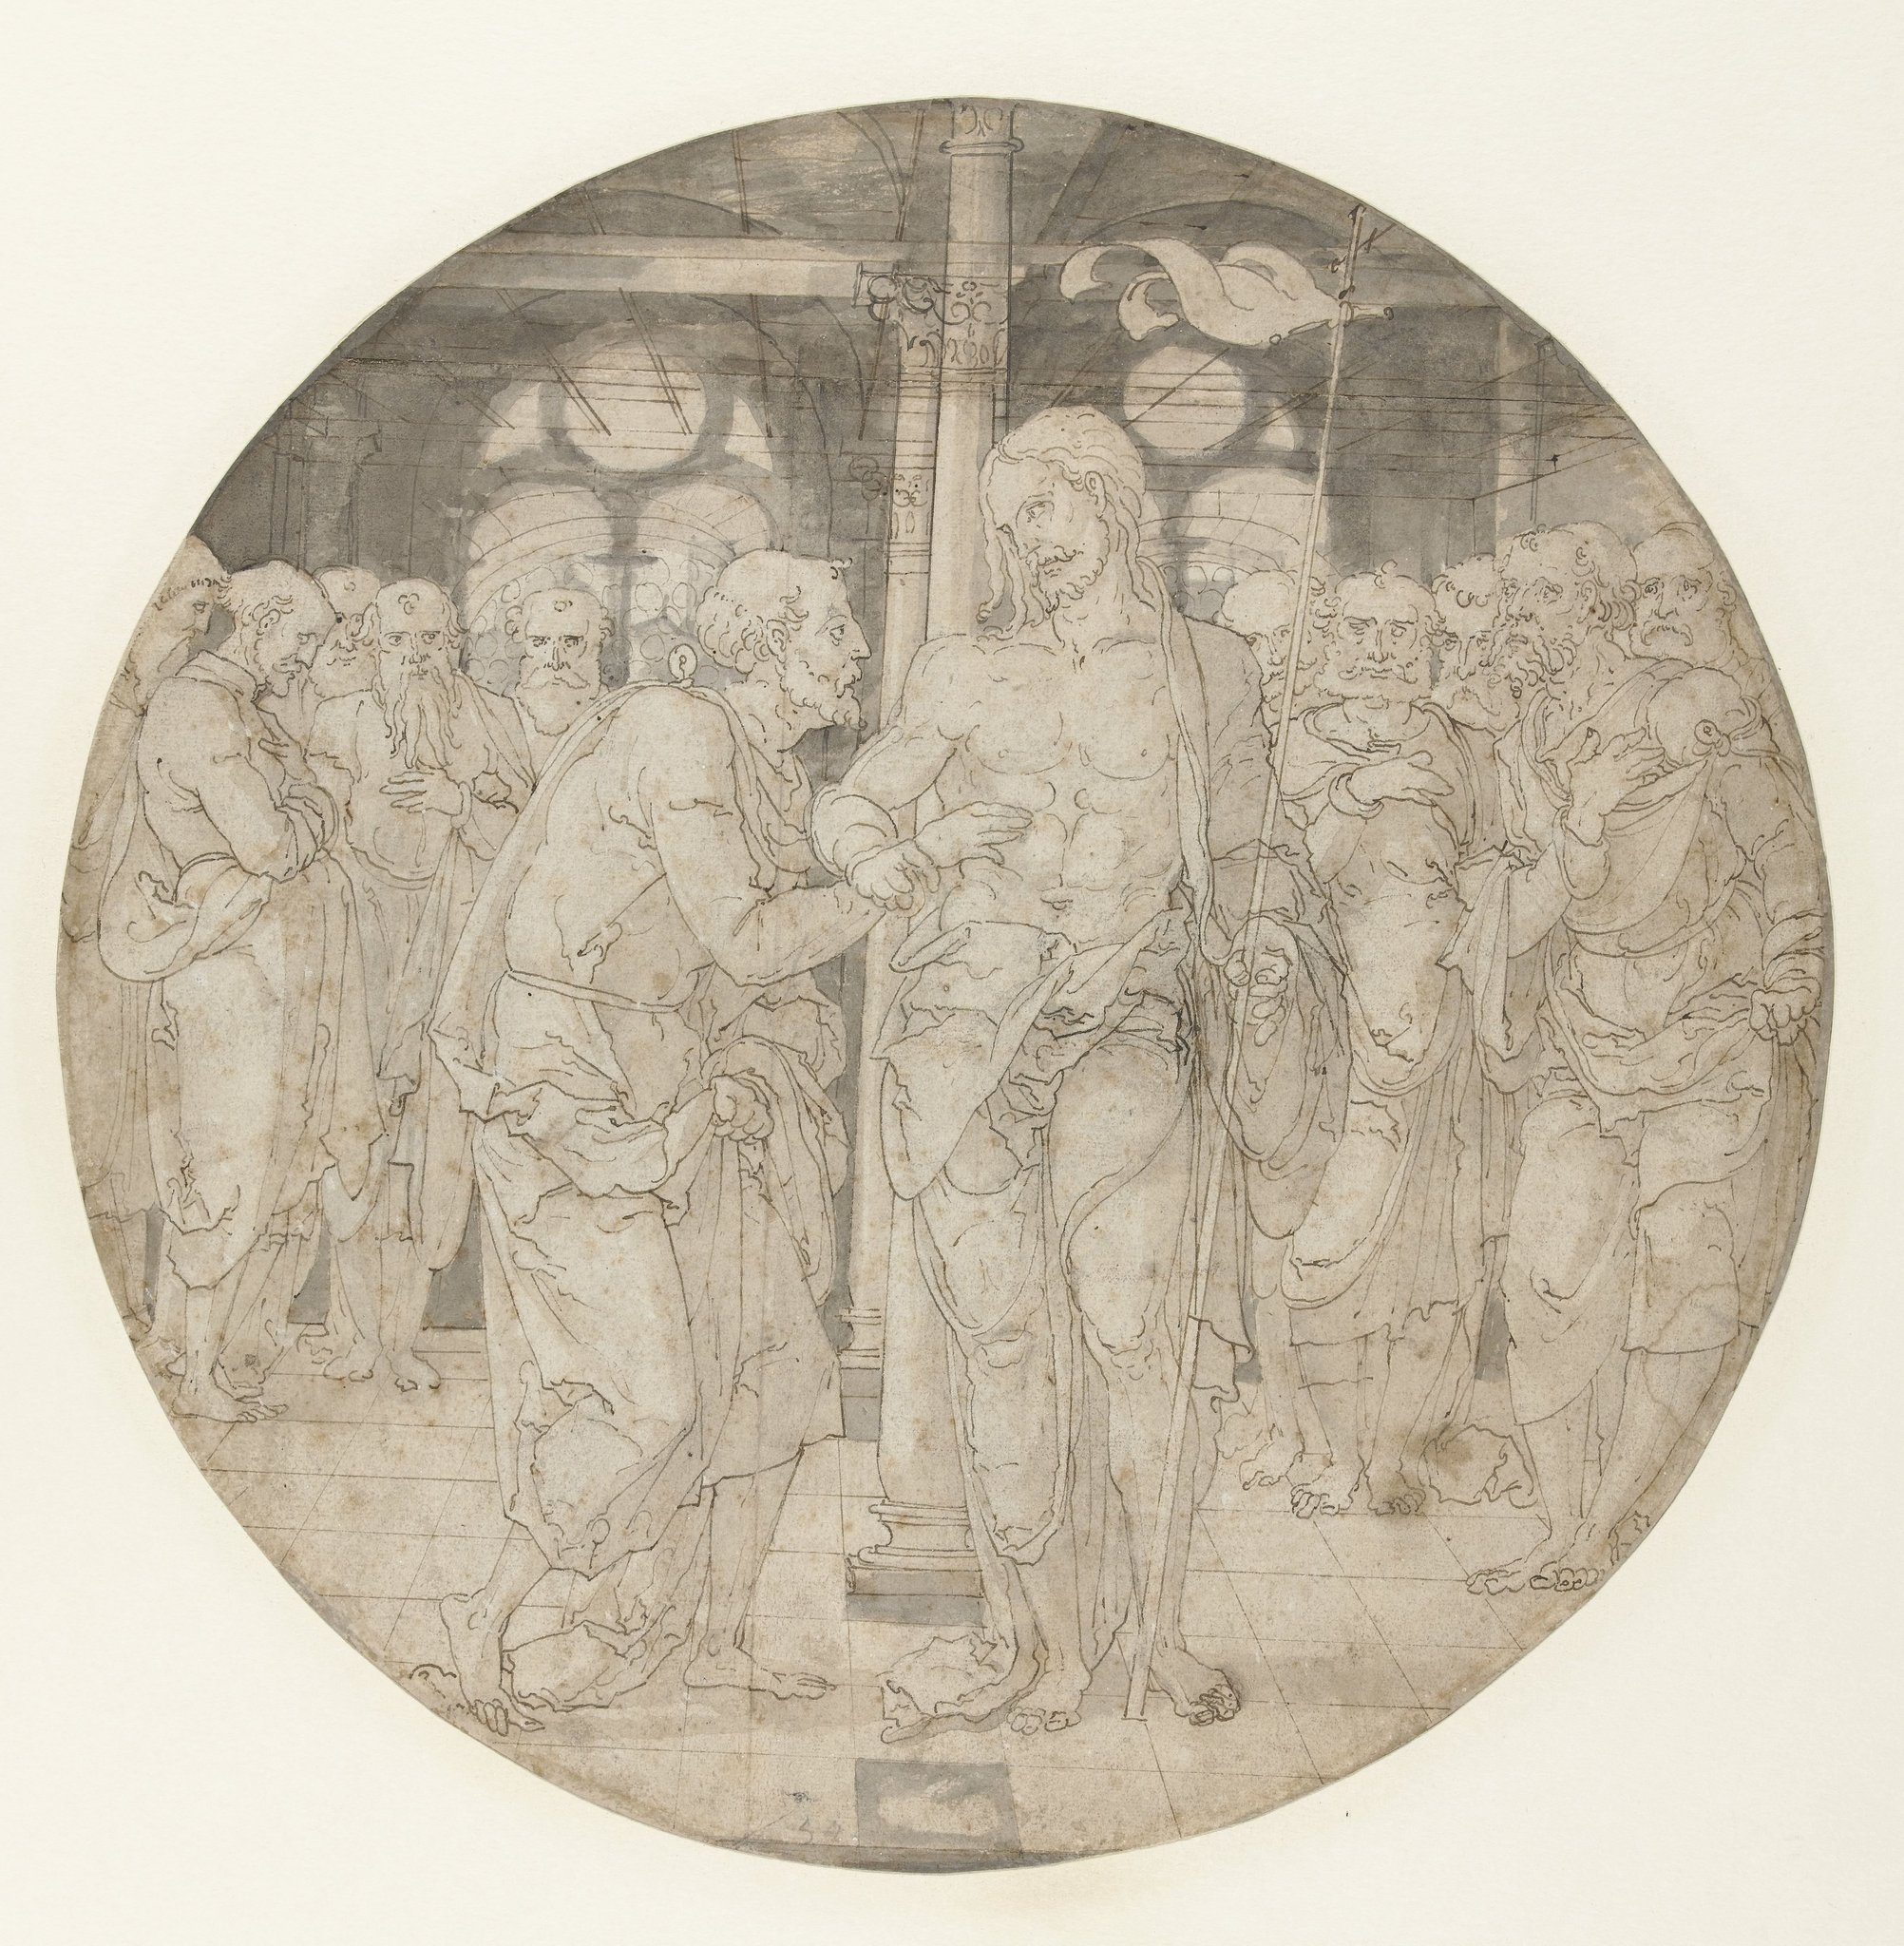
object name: design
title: Ongelovige Thomas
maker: nicolaas hogenberg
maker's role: draughtsman, painter, print maker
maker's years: 1500-1539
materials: ink, paper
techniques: brush, pen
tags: the incredulity of thomas